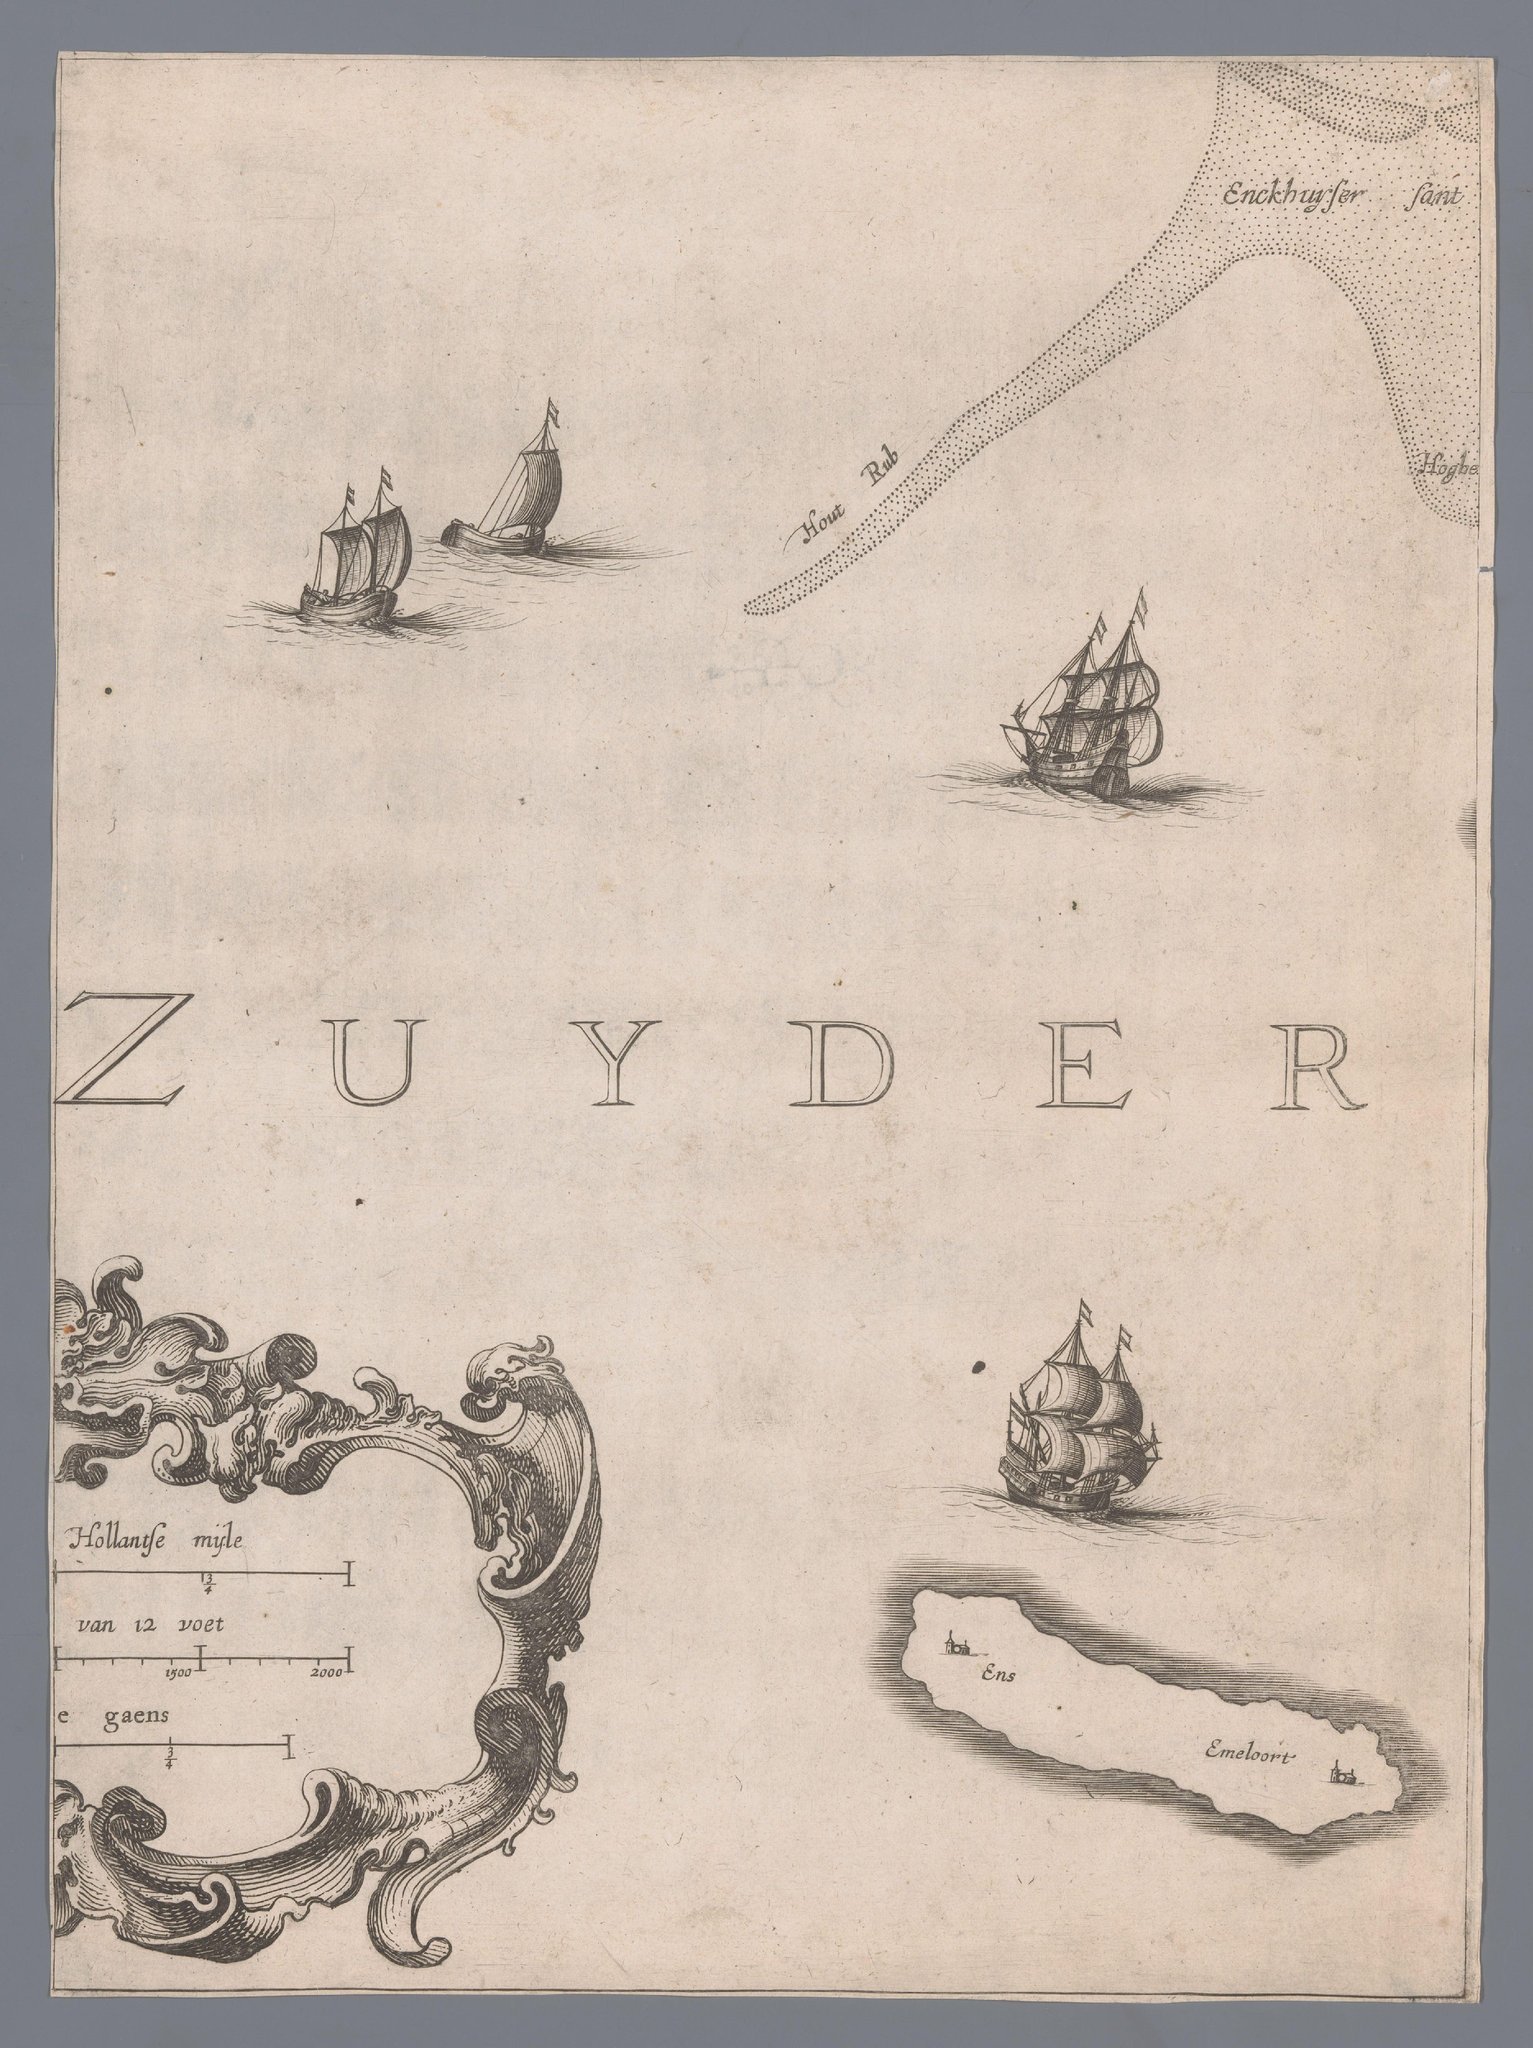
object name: map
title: Kaart van het Graafschap Holland en Utrecht (plaat 37)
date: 1639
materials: paper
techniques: engraving, etching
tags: sailing-ship, sailing-boat, maps, atlases, ornament ~ cartouche, holland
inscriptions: collector's mark: Lugt 2228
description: Onderdeel van een kaart samengesteld uit 40 bladen. Waarschijnlijk gaat het om de grootste kaart van Holland uit de zeventiende-eeuw. De kaart is uitgegeven in verschillende edities, deze kaart uit 1639 is de eerste editie.